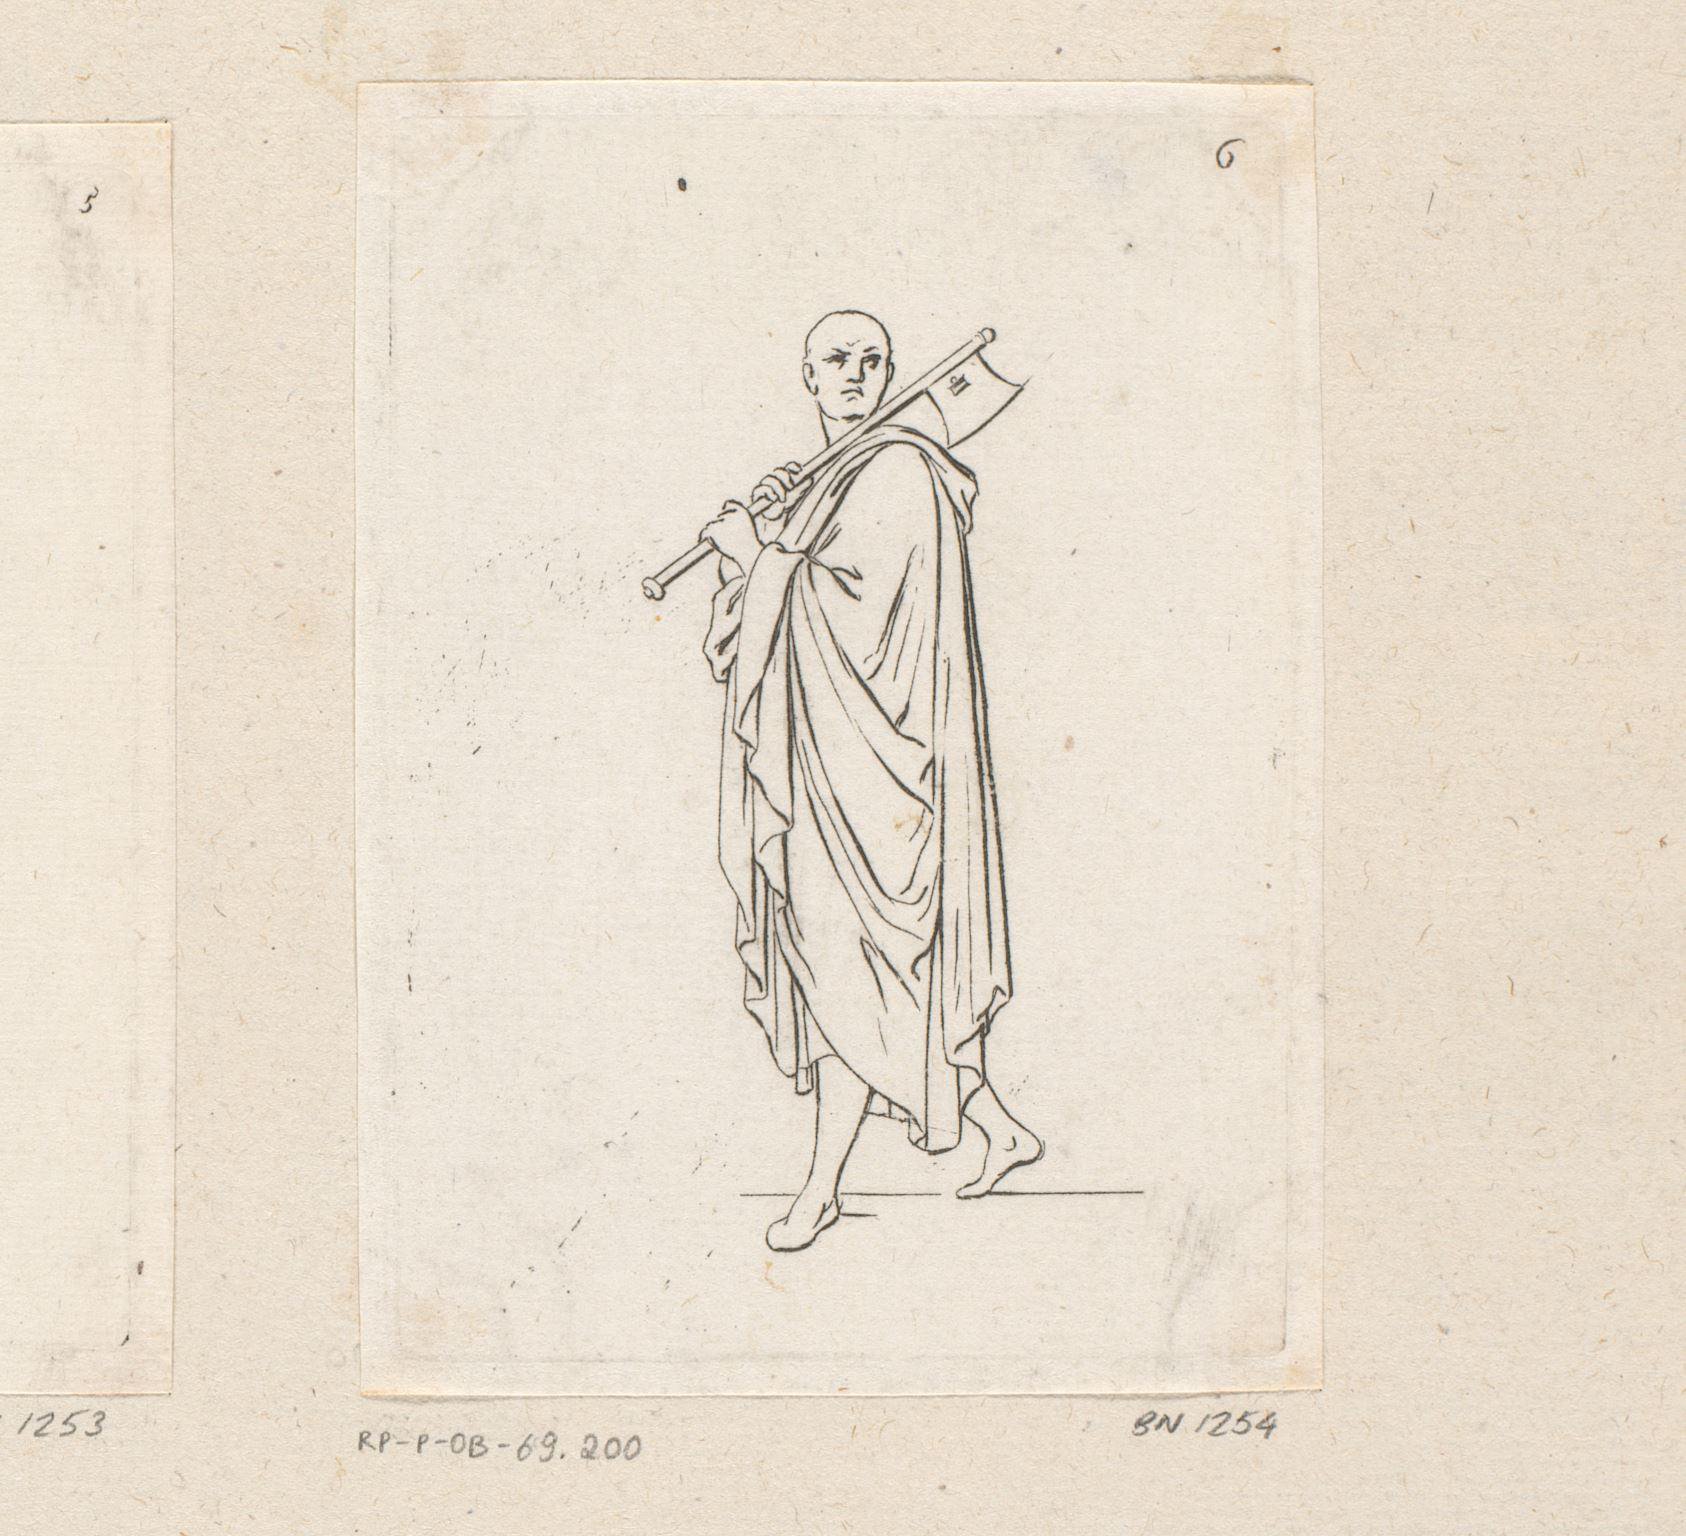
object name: print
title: Man met bijl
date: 1706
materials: paper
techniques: etching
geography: paris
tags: adult man, tools, aids, implements ~ crafts and industries: axe